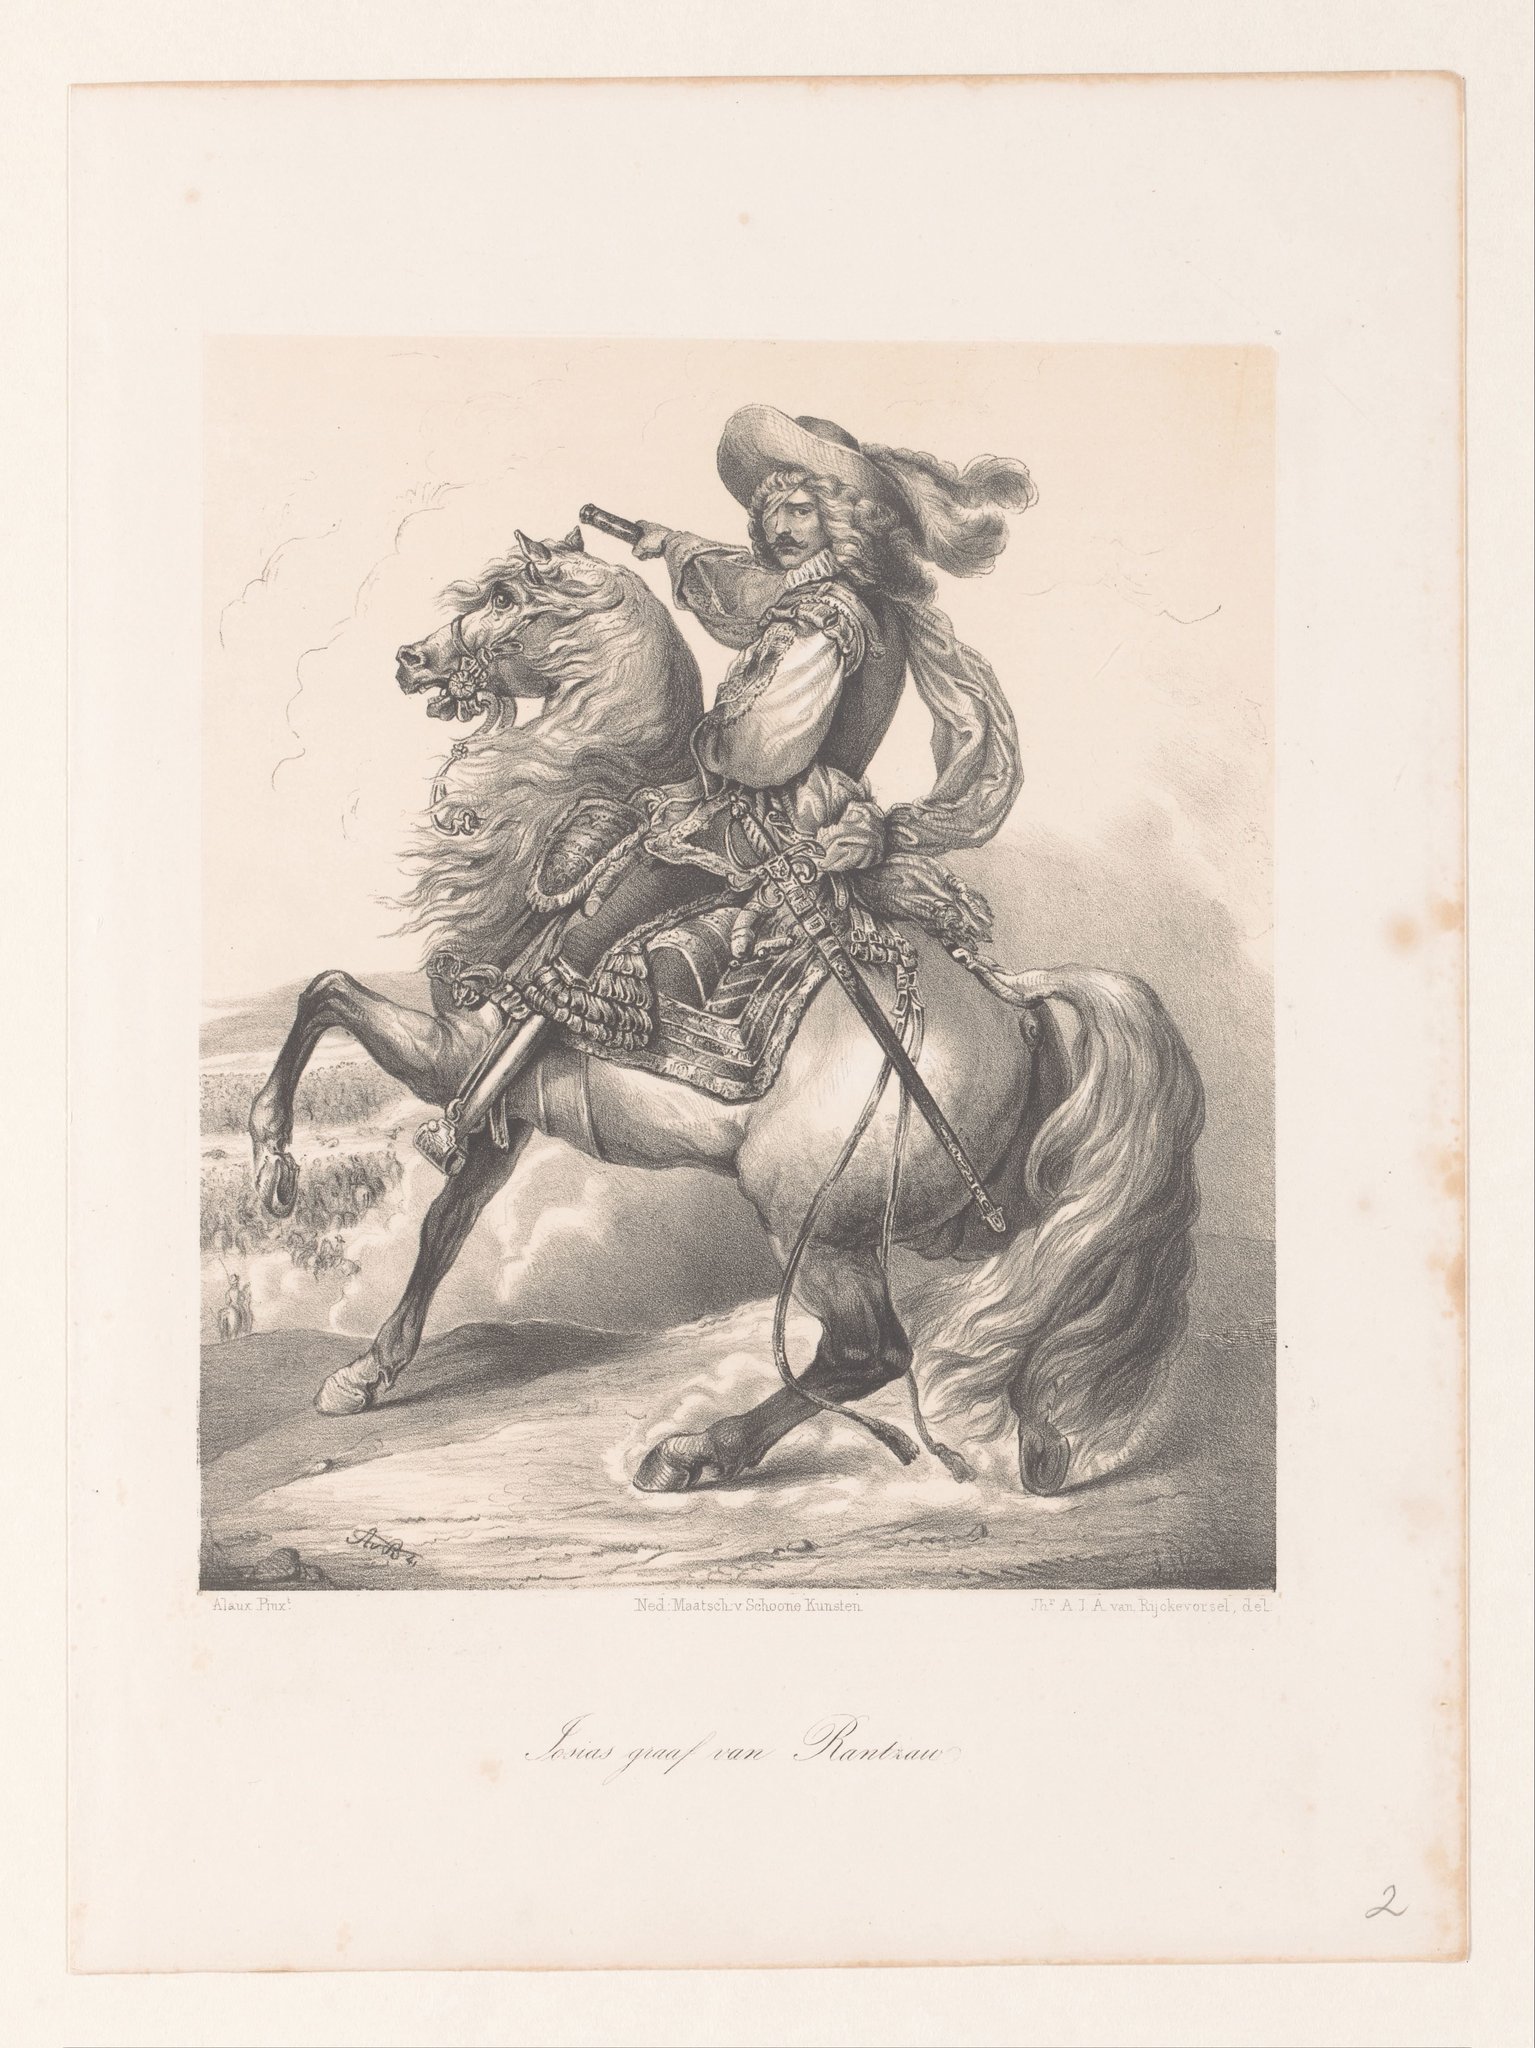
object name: print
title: Josias von Rantzau te paard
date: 1840-1843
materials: paper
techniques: tone lithography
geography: the hague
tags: riding a horse, ass, or mule; rider, horseman, commander-in-chief, general, marshal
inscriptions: collector's mark: Lugt 2228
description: Naar Josias von Rantzau te paard (1834) van Jean Alaux.